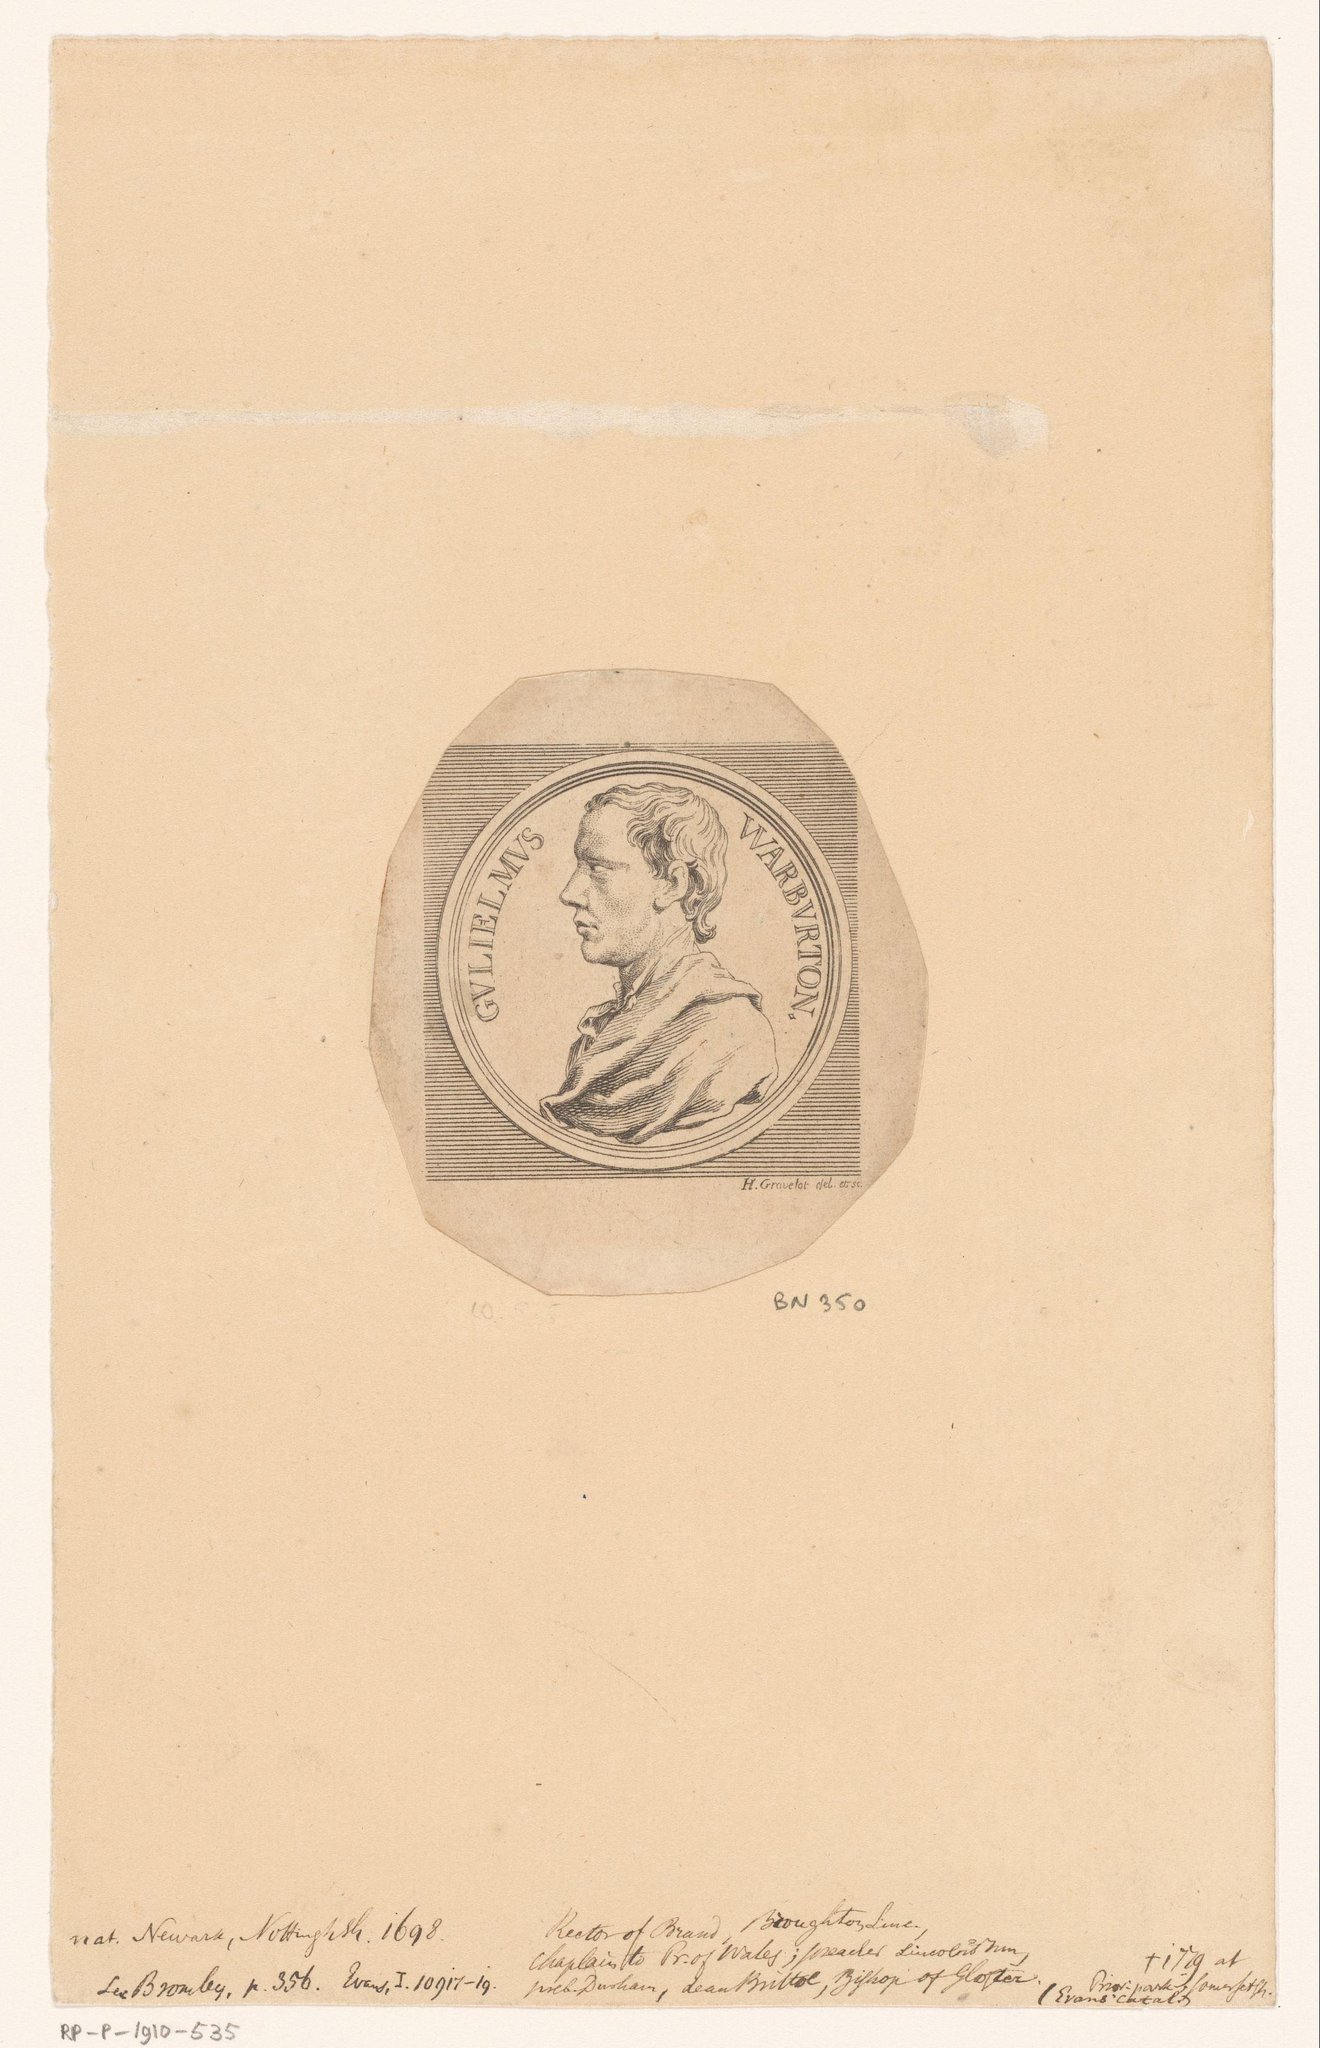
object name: print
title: Portret van William Warburton in een medaillon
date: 1742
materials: paper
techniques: etching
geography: london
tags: priest, archbishop, bishop, etc. (roman catholic), historical persons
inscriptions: collector's mark: Lugt 2228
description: Prent uit: Warburton, William. Dissertation sur l'union de la religion, de la morale et de la politique. Londen: G. Darrès, 1742.